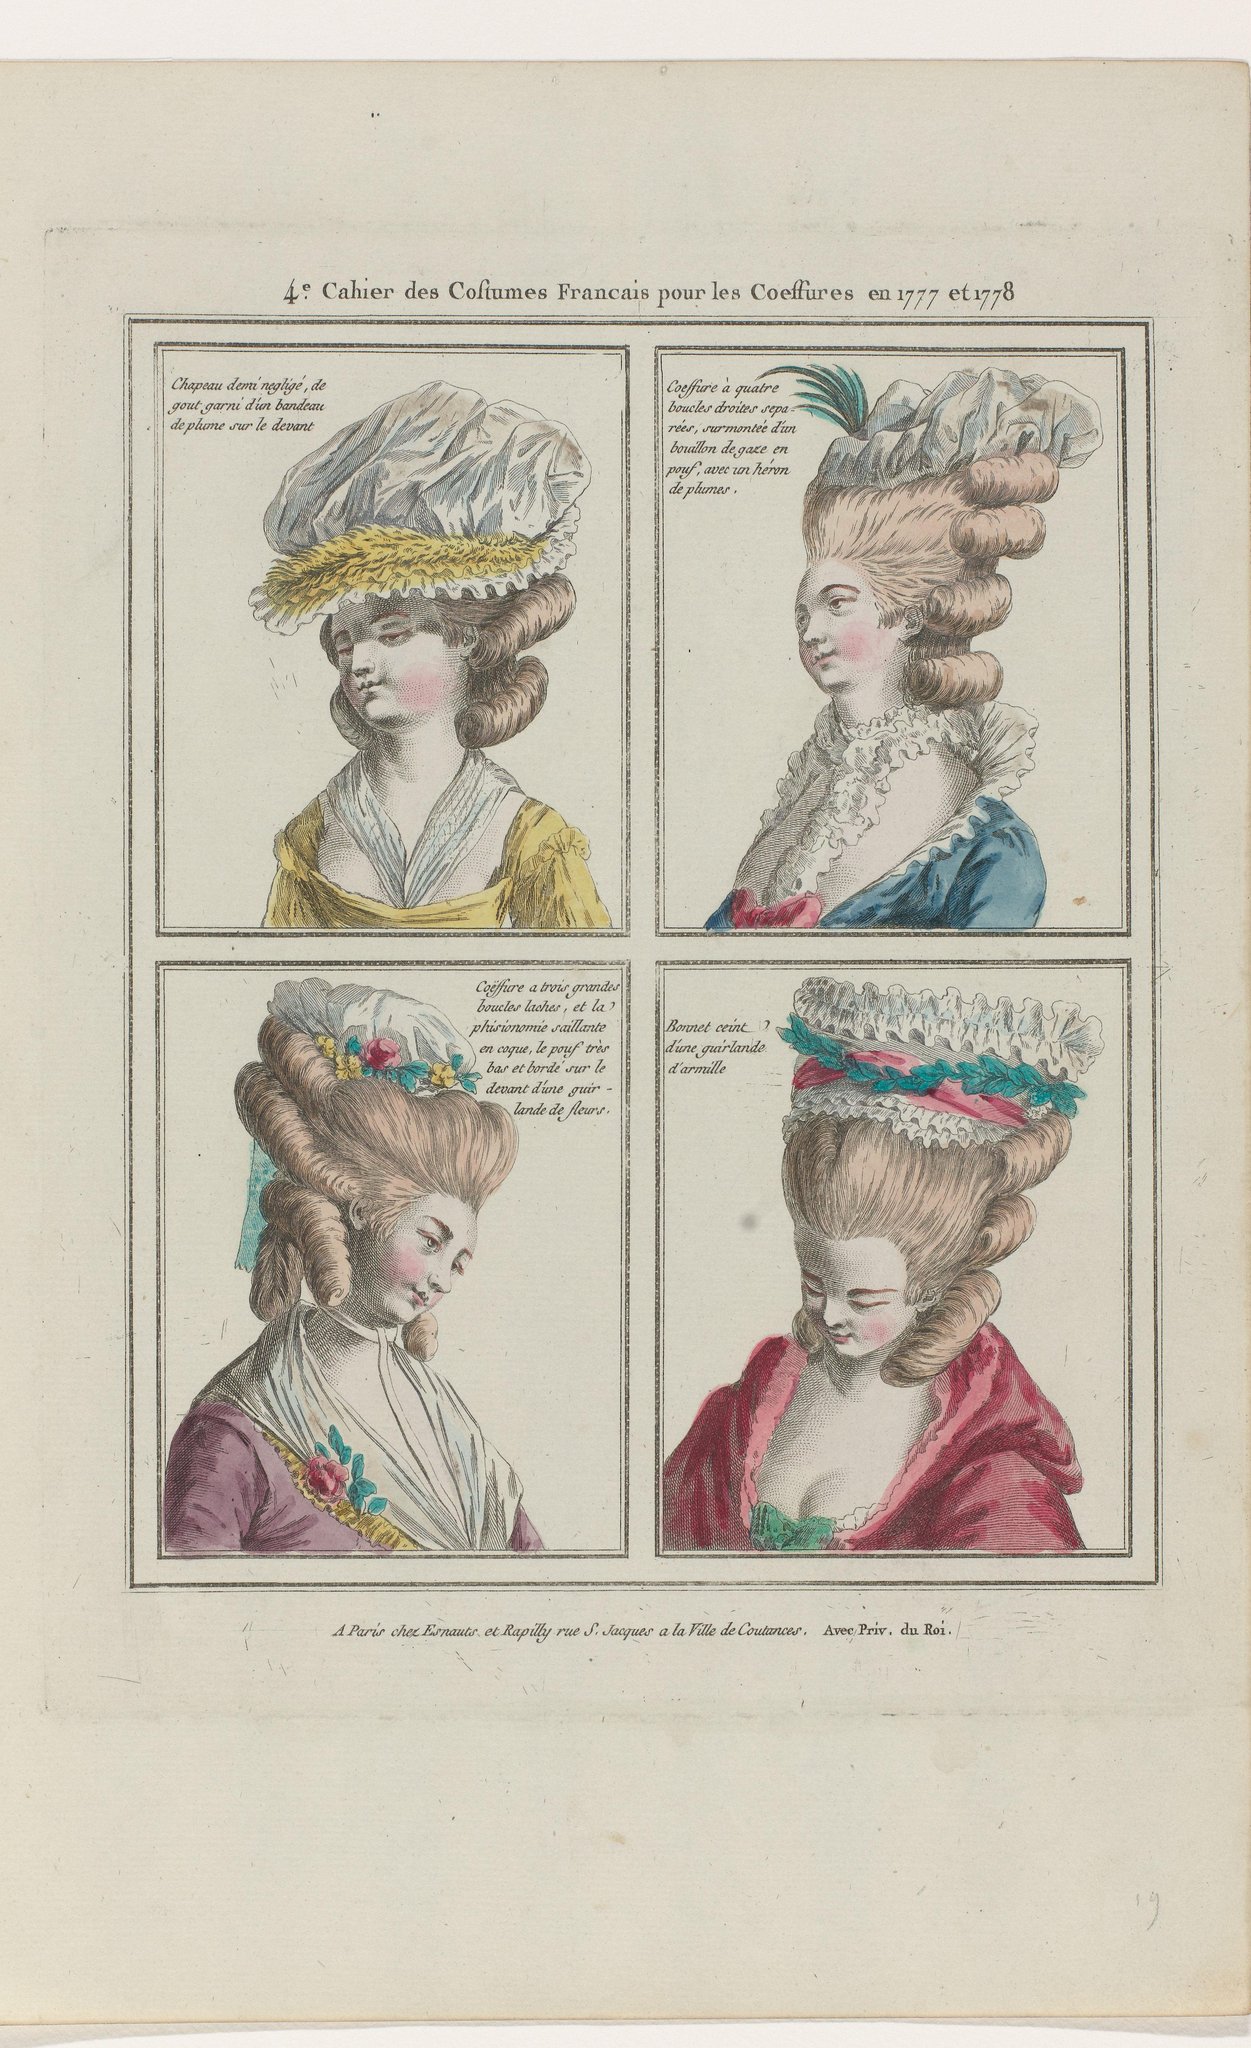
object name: fashion print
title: Gallerie des Modes et Costumes Français, 1777-1778, D 19 : Chapeau demi négligé (...)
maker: Anonymous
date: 1778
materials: paper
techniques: engraving, hand coloring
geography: paris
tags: corsage (+ women's clothes), flowers, clothing for the upper part of the body (+ women's clothes), head-gear (pouf) (+ women's clothes), piece of clothing covering the breast or décolleté (fichu) (+ lace used for clothes), styles of hairdress - aa - ~ women, head-gear: cap (+ women's clothes), fashion plates, head-gear: hat (+ women's clothes)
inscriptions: inscription: ‘Chapeau demi negligé, de gout garni d'un bandeau de plume sur le devant’, title: ‘4e Cahier des Costumes Francais pour les Coeffures en 1777 et 1778’, inscription: ‘Bonnet ceint d'une guirlande d'armille’, address: ‘A Paris chez Esnauts et Rapilly rue S. Jacques a la Ville de Coutances. Avec Priv. du Roi’, inscription: ‘Coeffure à quatre boucles droites separées, surmontée d'un bouillon de gaze en pouf, avec un héron de plumes.’, inscription: ‘Coëffure a trois grandes boucles laches, et la phisionomie saillante en coque, le pouf très bas et bordé sur le devant d'une guirlande de fleurs’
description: Vier vrouwenkapsels met grote krullen en verschillende hoofddeksels, verdeeld in kaders. Van linksboven naar rechtsonder: Chapeau demi negligé, de gout garni d'un bandeau de plume sur le devant. Coeffure à quatre boucles droites separées, surmontée d'un bouillon de gaze en pouf, avec un héron de plumes. Coëffure a trois grandes boucles laches, et la phisionomie saillante en coque, le pouf très bas et bordé sur le devant d'une guirlande de fleurs. Bonnet ceint d'une guirlande d'armille. Prent uit serie D. 4e Cahier des Costumes Français pour les Coeffures en 1777 et 1778, Gallerie des Modes et Costumes Français.